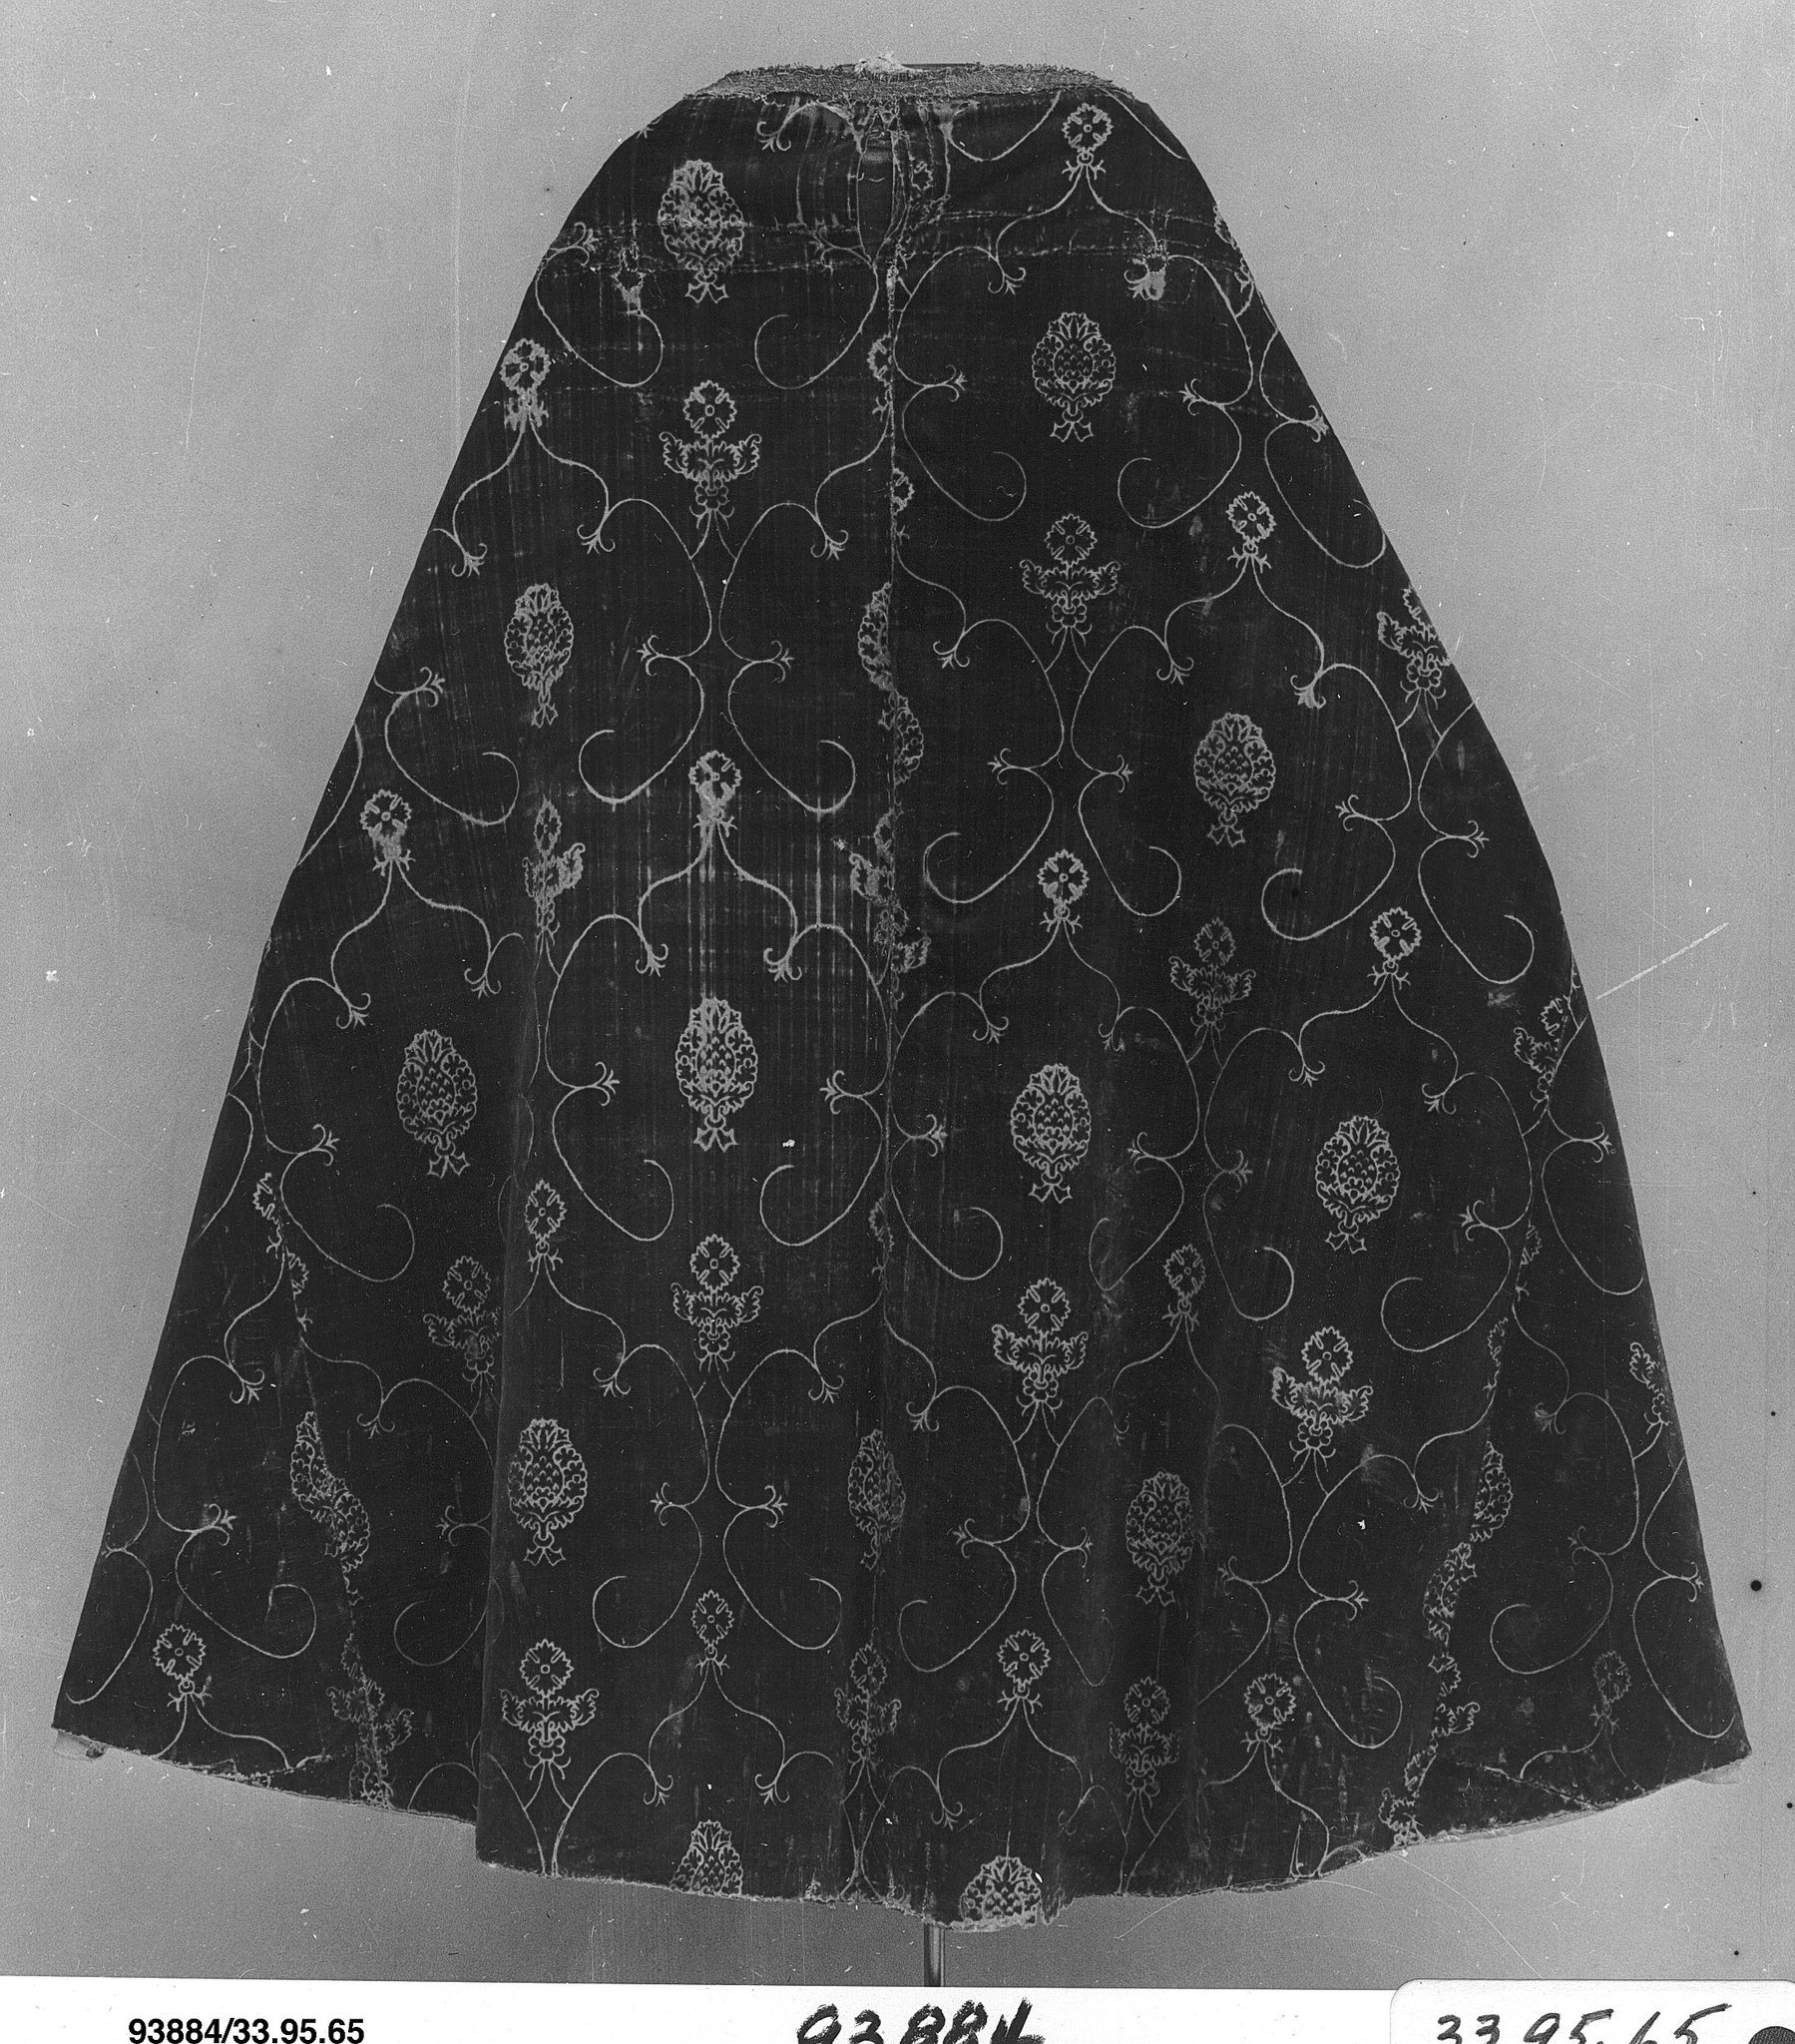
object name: cope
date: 1501-1533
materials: silk